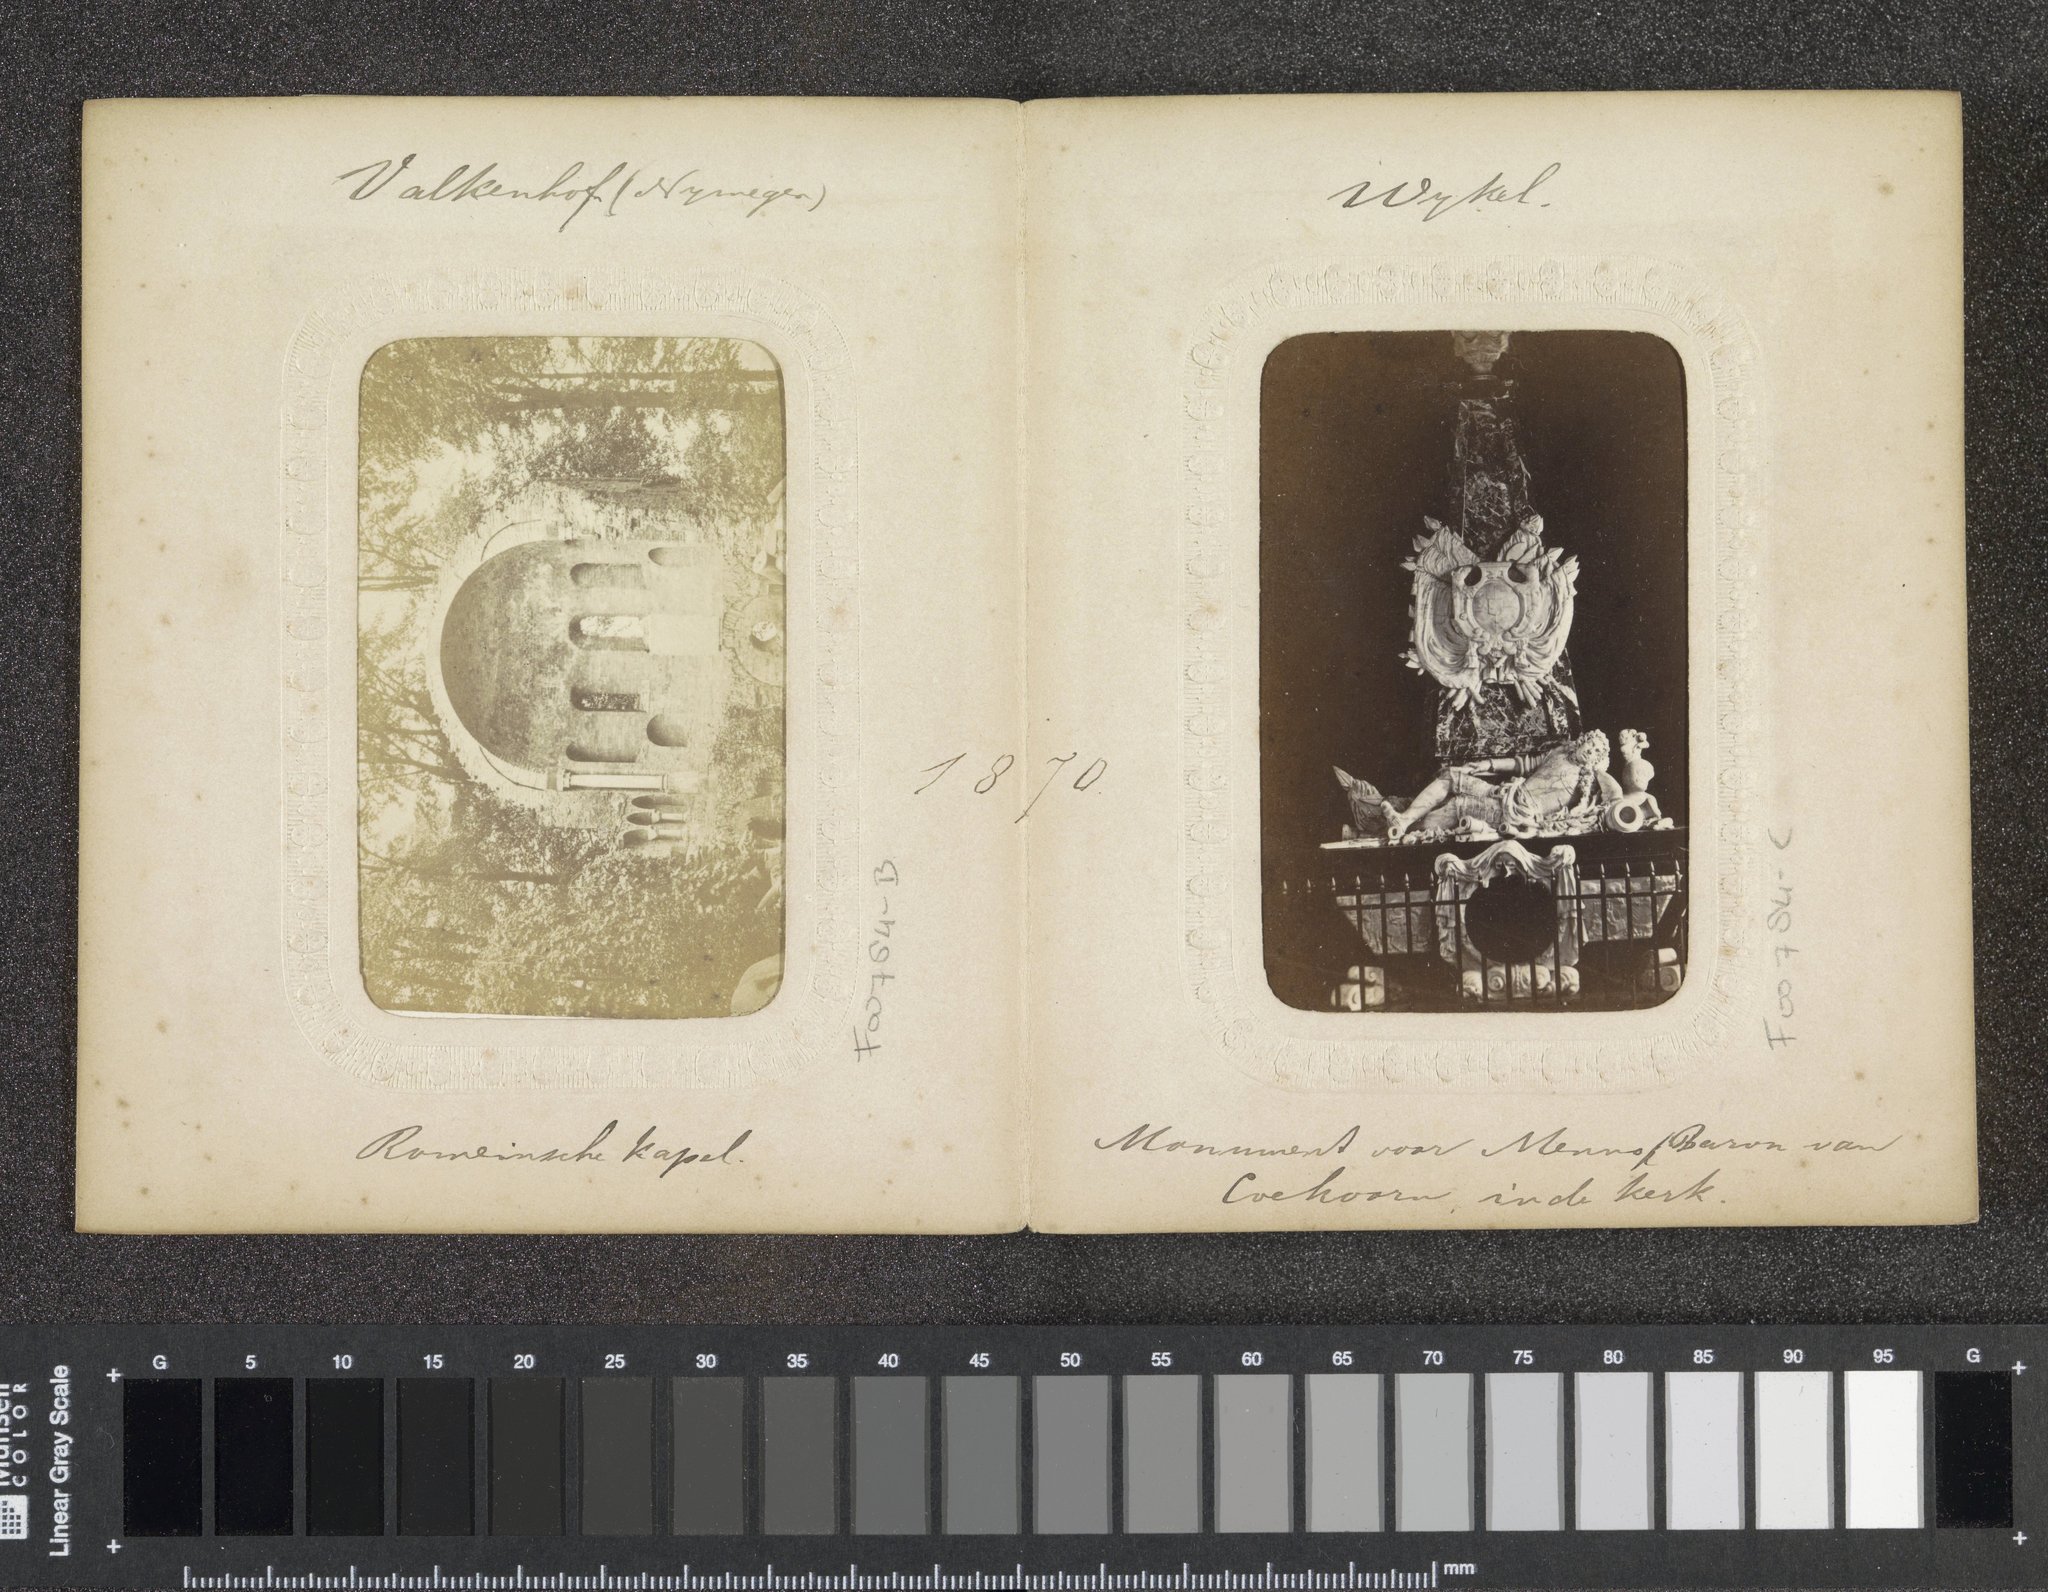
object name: album leaf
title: Valkenhof (Nijmegen) Romeinsche kapel.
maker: julius cornelius schaarwächter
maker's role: fotograaf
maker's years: 1847-1904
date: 1870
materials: cardboard, paper, photographic support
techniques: albumen print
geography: nijmegen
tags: church (exterior) - qq - small church, chapel, public gardens, park, ruin of a dwelling, house, castle, etc., nijmegen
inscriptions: inscription: ‘Tentoonst: v: Photogr: 1858’, name: ‘Egbert de Vries’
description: Onderdeel van Fotoalbum met bezienswaardigheden in Nederlandse, Belgische en Duitse steden.